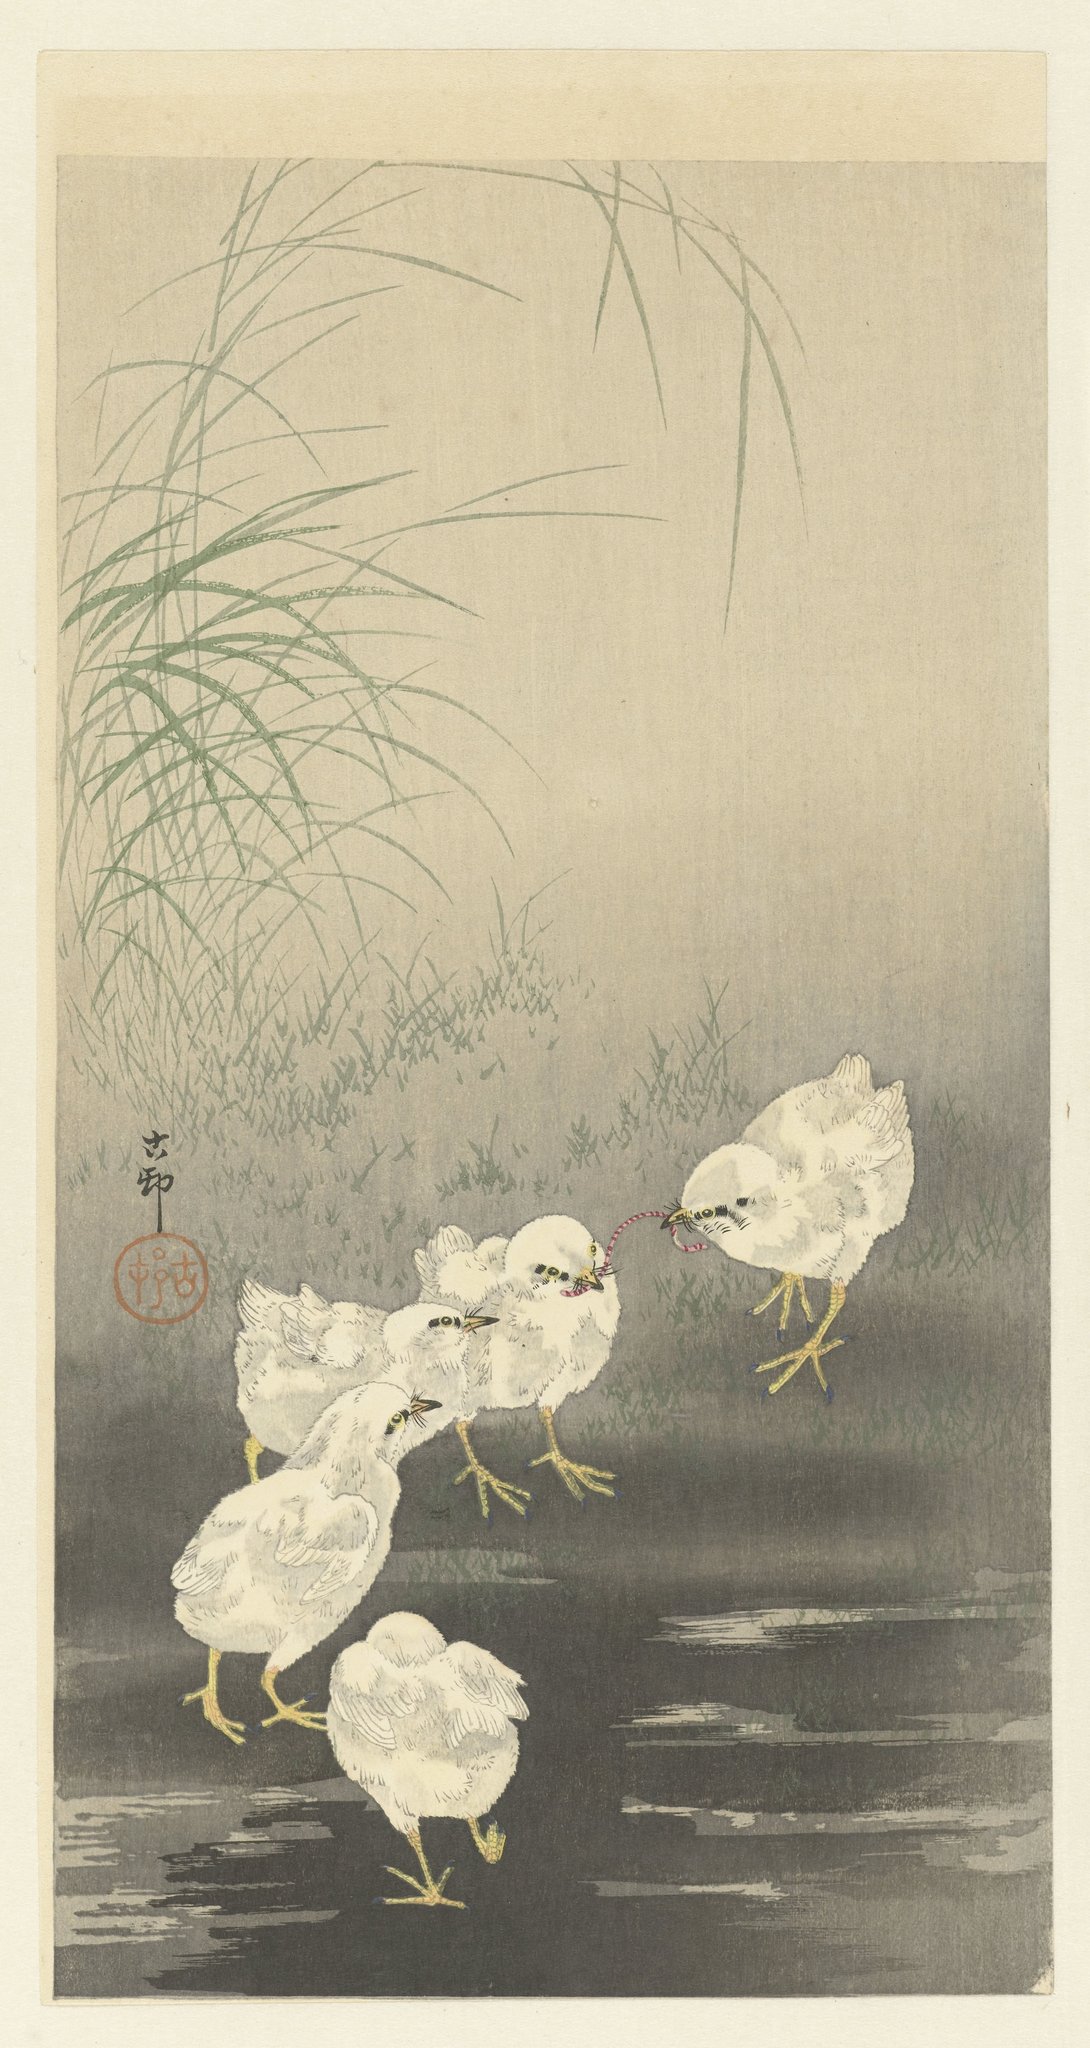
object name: print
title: Chicks and Worm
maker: ohara koson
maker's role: print maker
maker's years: 1877-1945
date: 1900-1930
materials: paper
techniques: woodcut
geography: tokyo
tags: fowl (cock, hen, chicken, etc.) (+ young animal)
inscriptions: collector's mark: Lugt 2228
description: Vijf kuikens: twee vechtend om een worm, drie toekijkend; bij grashalmen.